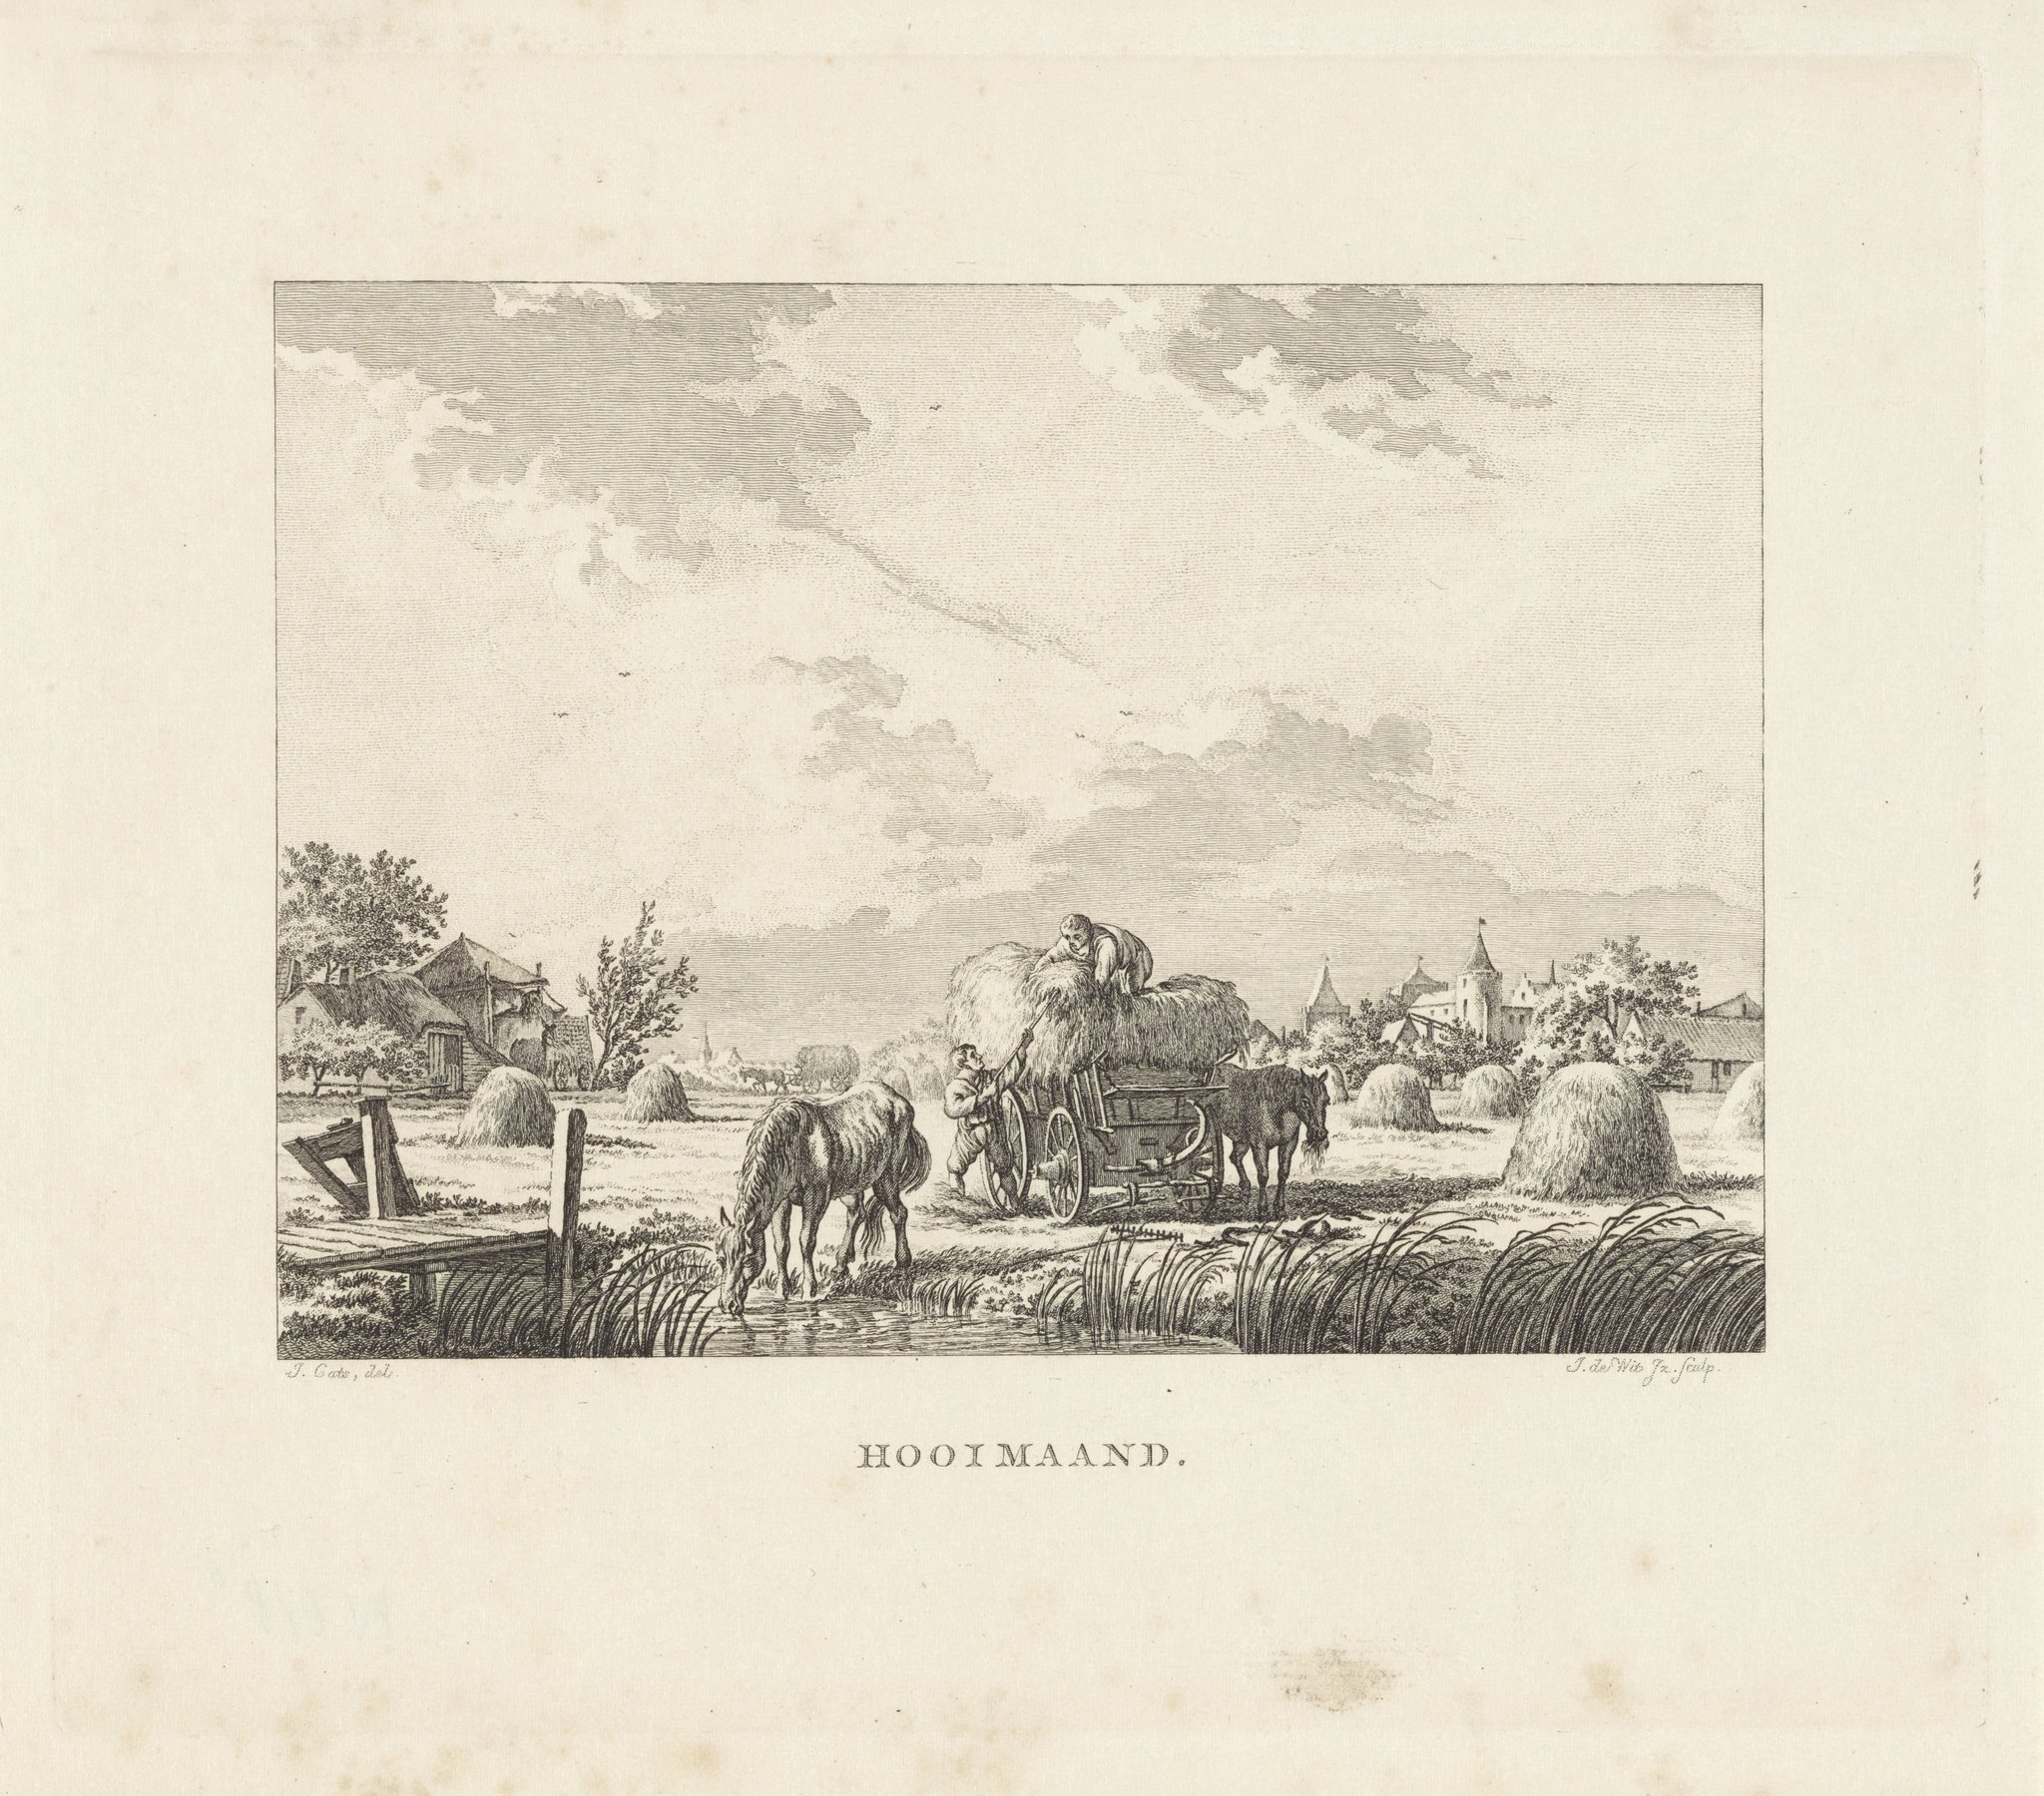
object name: print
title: Twee boeren oogsten hooi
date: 1806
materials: paper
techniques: etching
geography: haarlem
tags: july and its 'labours' (+ with scenes showing human occupations ~ seasons and months), horse, hay-stack, hay-wagon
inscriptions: collector's mark: Lugt 2228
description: Hooi wordt op een wagen geladen. Een drinkend paard op de voorgrond.